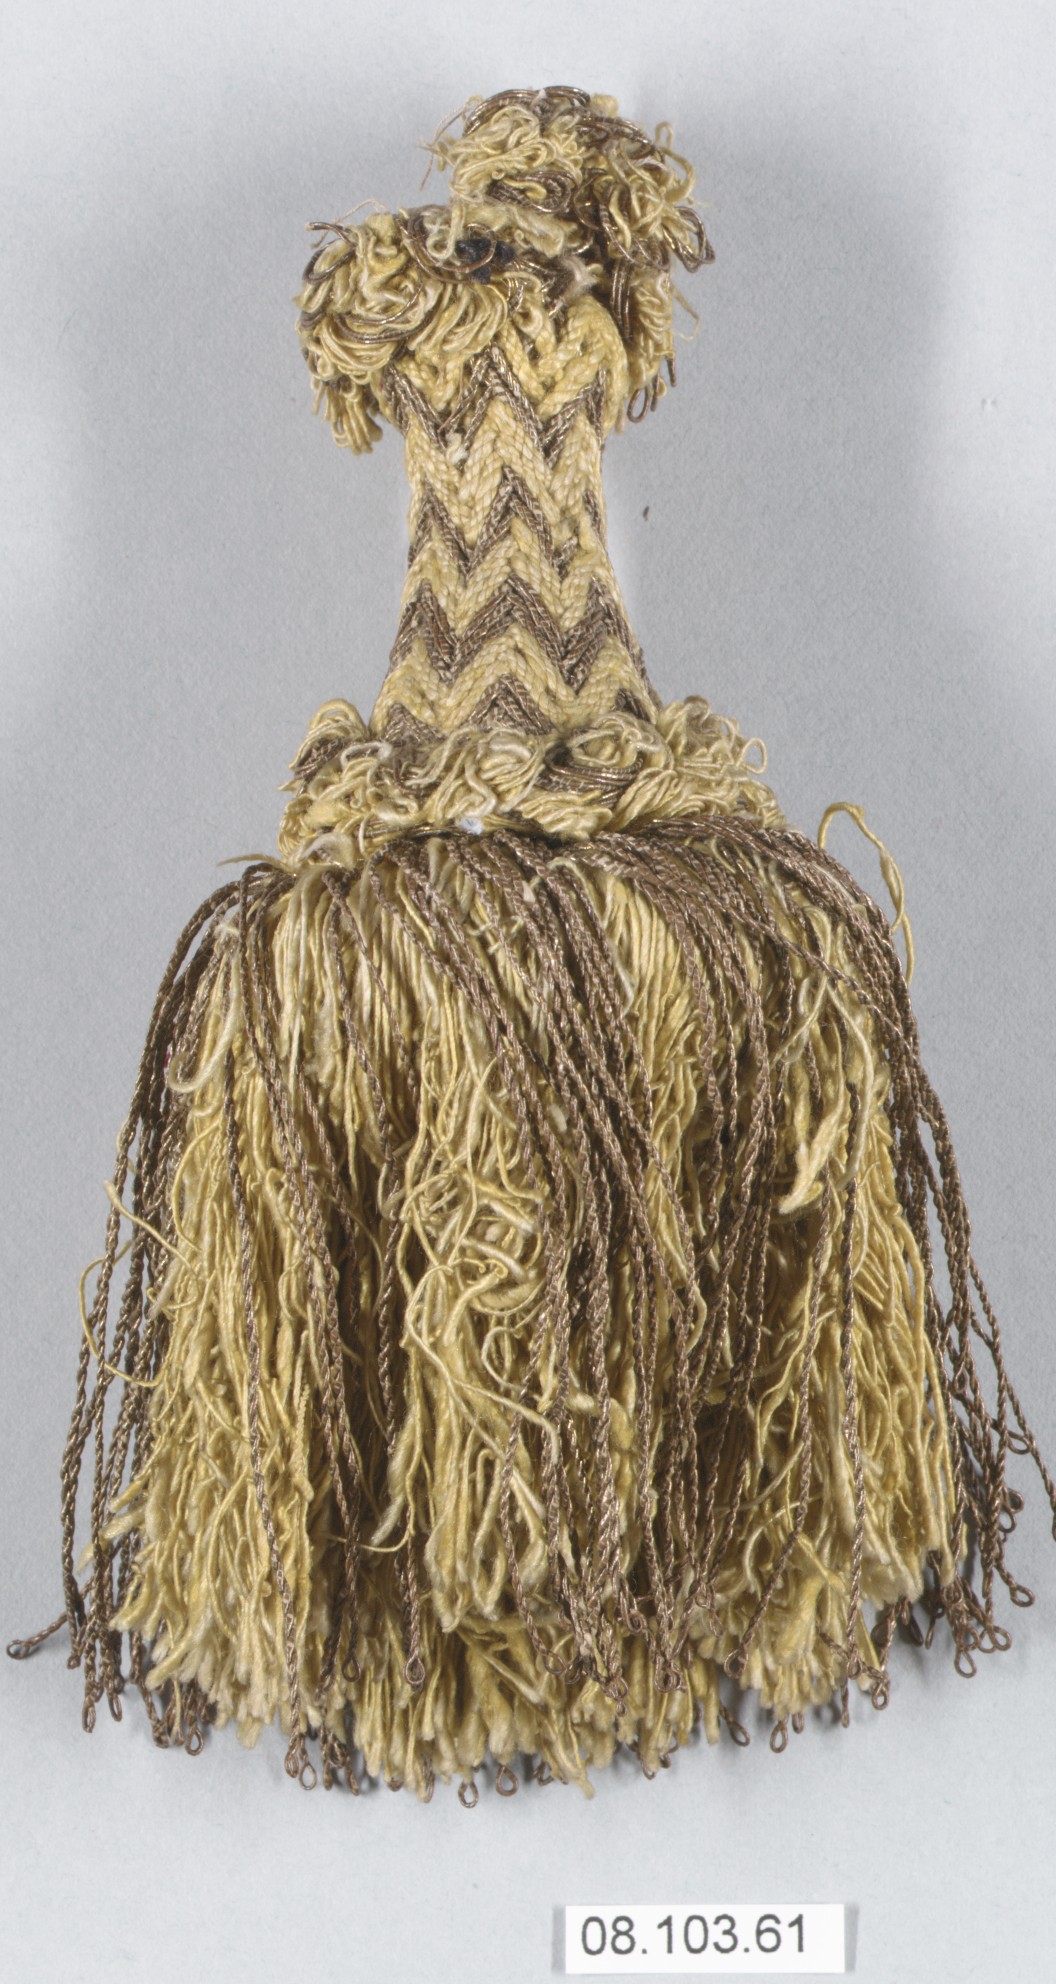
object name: tassel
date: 1501-1600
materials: cotton, metal thread